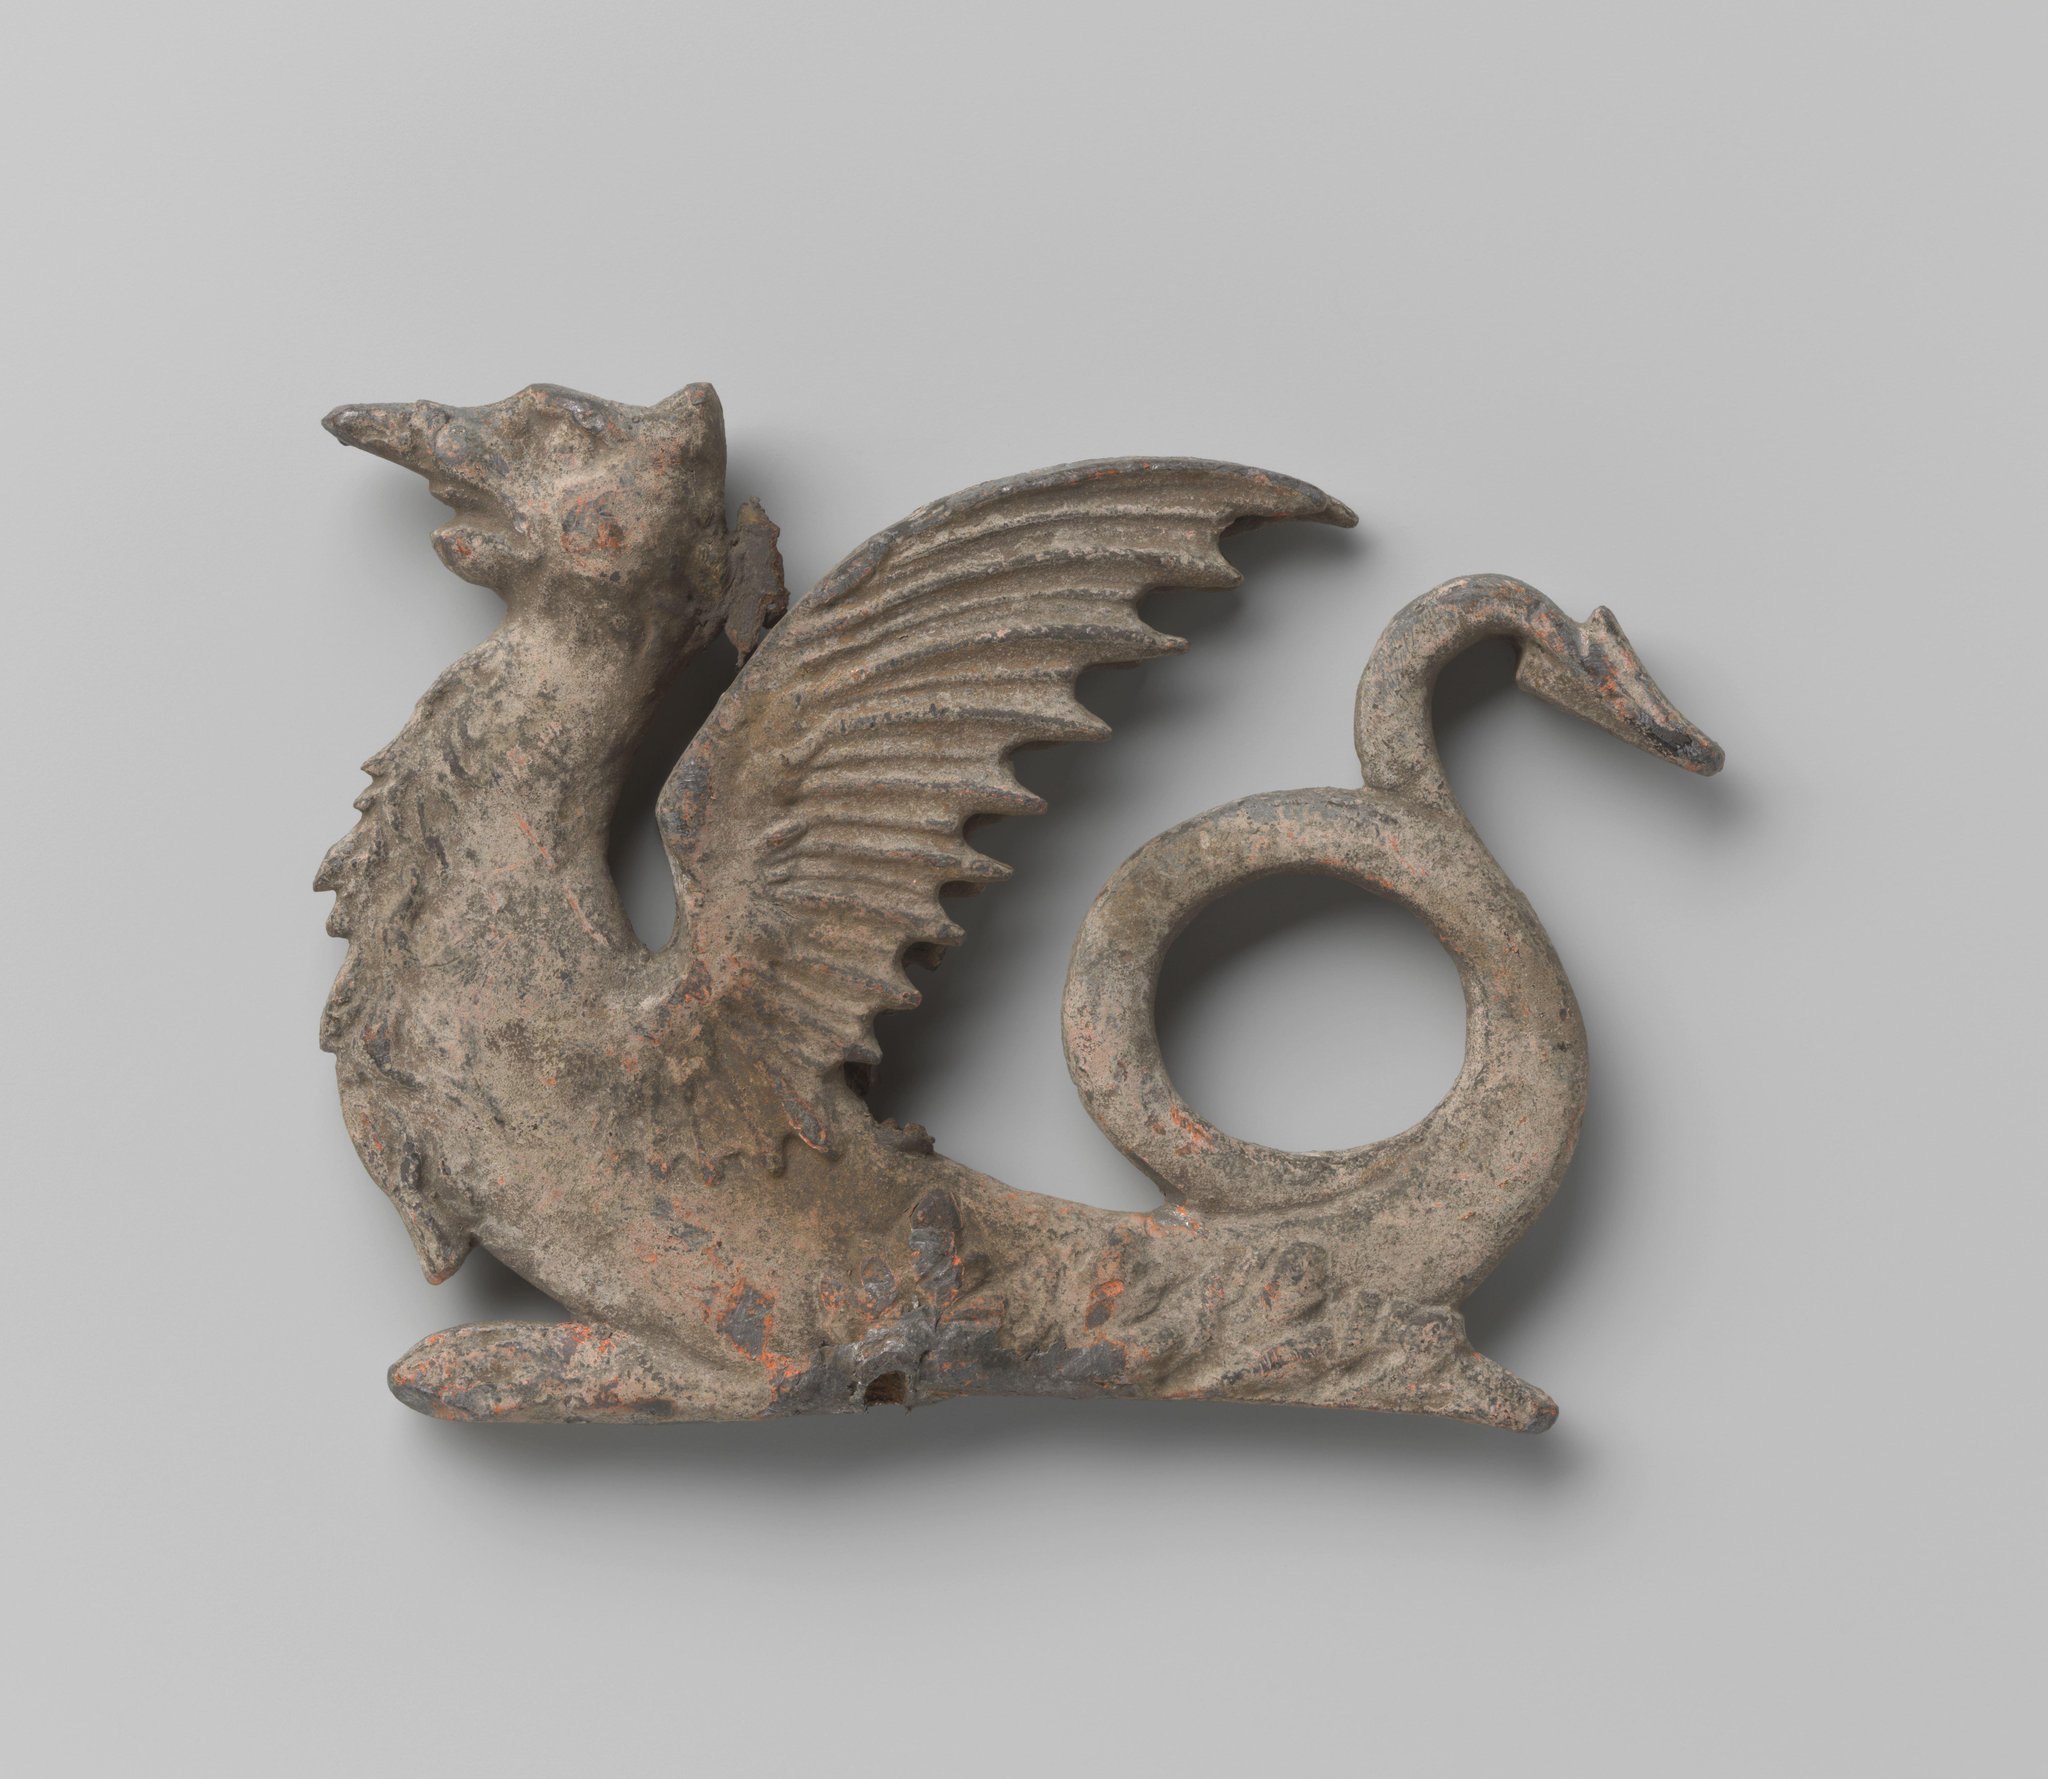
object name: sundial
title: Loden draak van zonnewijzer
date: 1650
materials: lead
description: Loden draak, onderdeel van de ijzeren zonnewijzer.